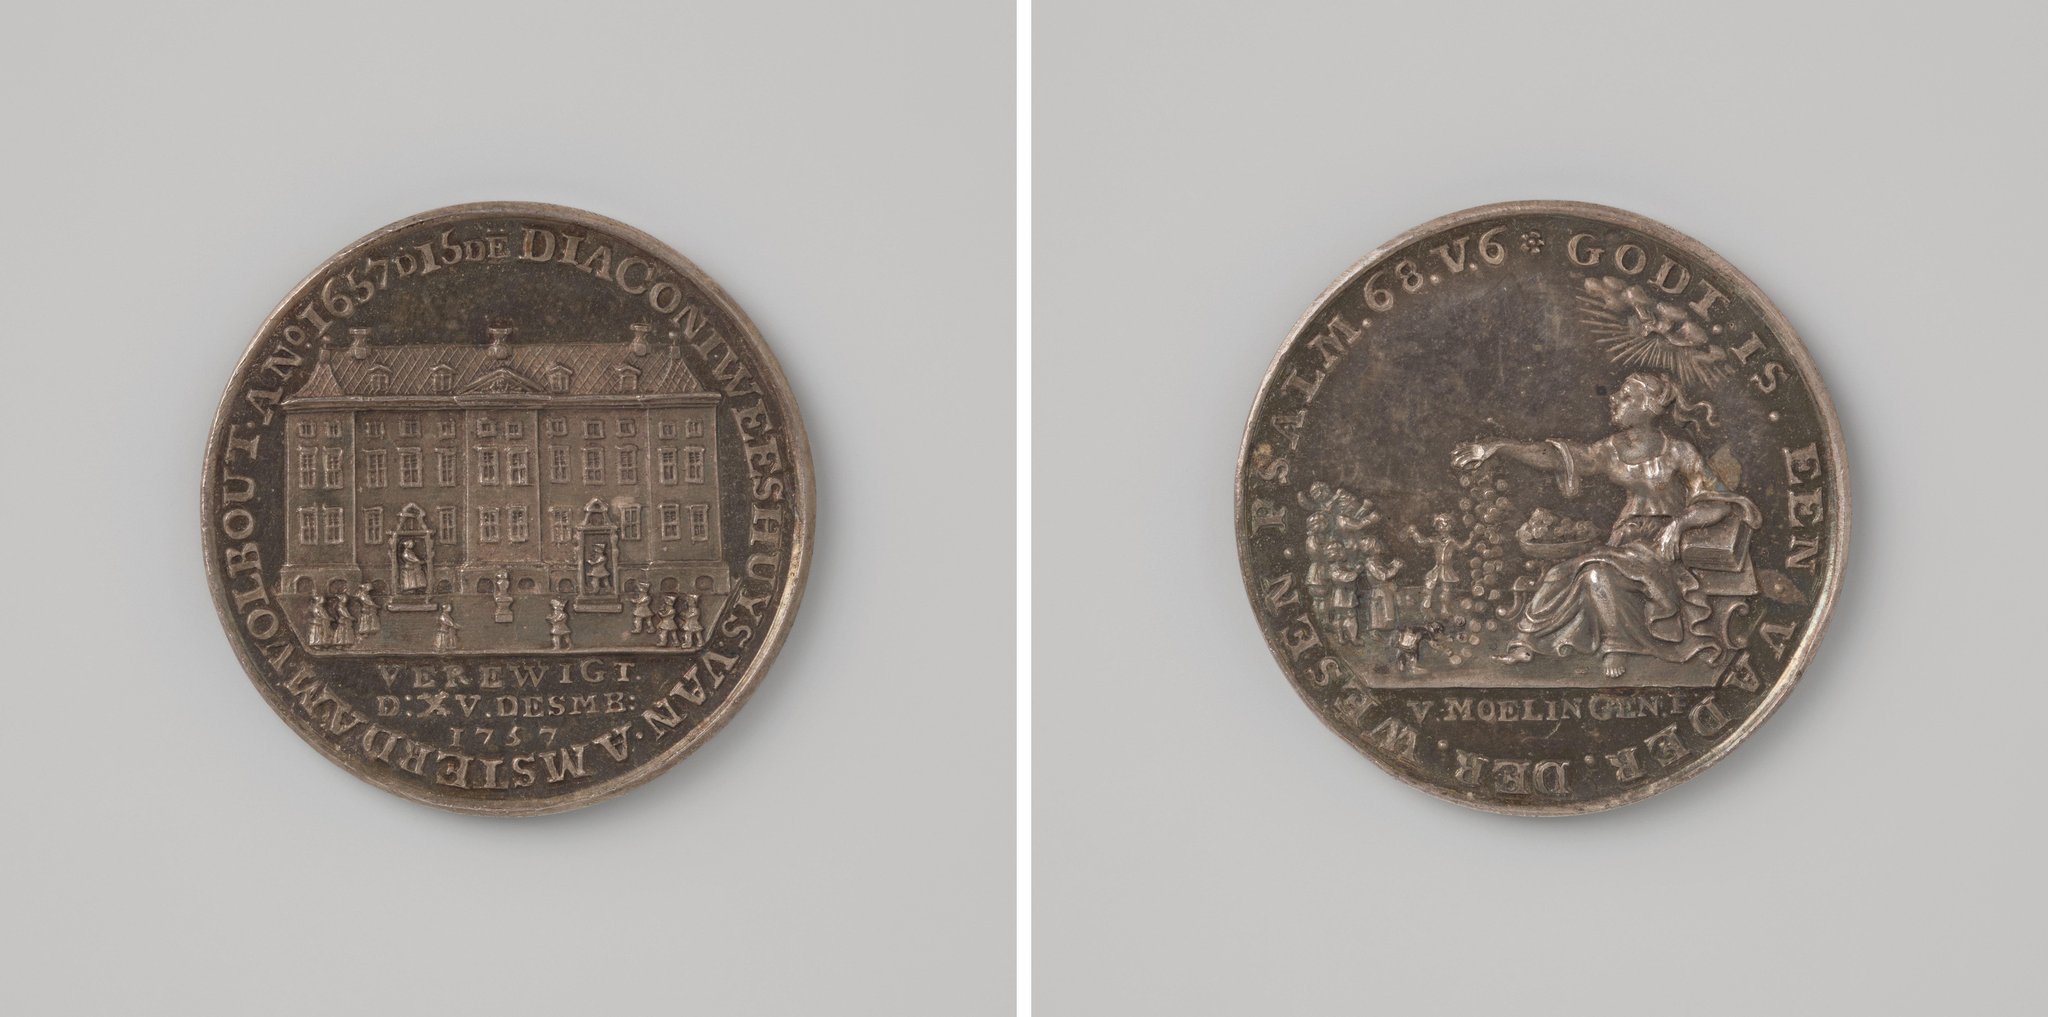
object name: history medal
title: Eeuwfeest van het Diaconieweeshuis te Amsterdam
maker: gerrit van moelingen (ii)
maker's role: die cutter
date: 1757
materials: silver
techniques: striking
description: Zilveren penning, op de voorzijde het weeshuis, waarvoor kinderen en een armenbus, met omschrift en afsnedetekst, op de keerzijde de Milddadigheid die muntgeld uitstrooit voor kinderen, met omschrift en afsnedetekst.